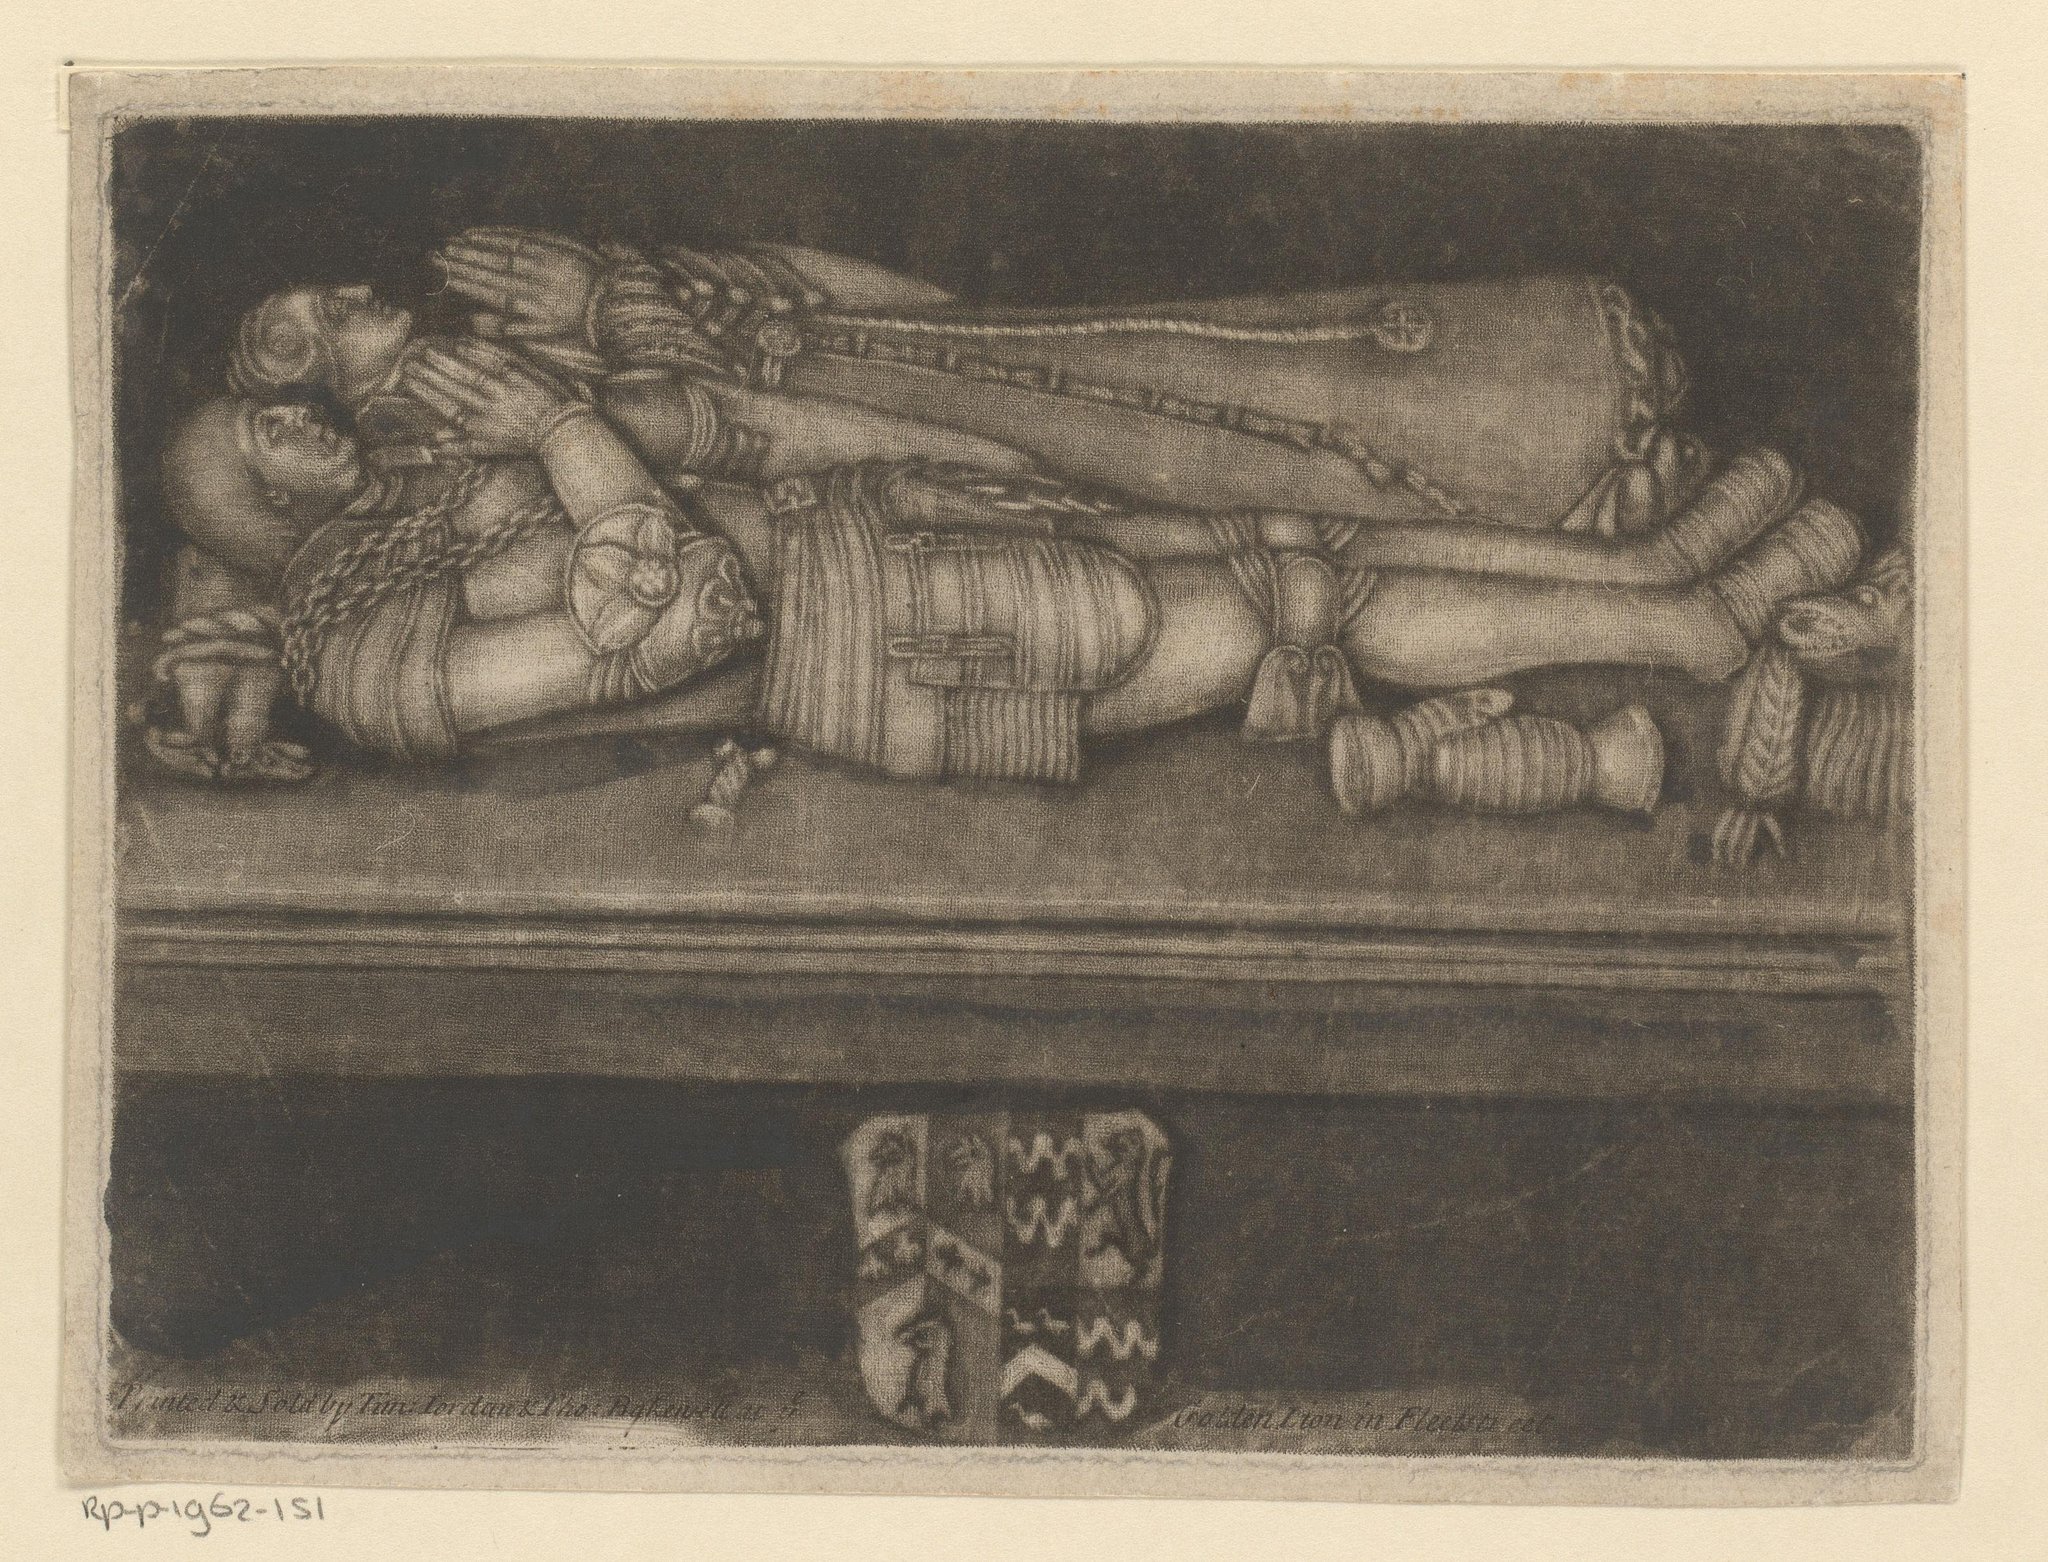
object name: print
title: Grafmonument van Thomas Pope en Elizabeth Blount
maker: Anonymous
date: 1729-1749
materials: paper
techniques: mezzotint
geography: fleet street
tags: historical persons - bb - woman, historical persons, grave, tomb, monument, statue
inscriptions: inscription: ‘Sir Thomas Pope (...) 23.10.1963’